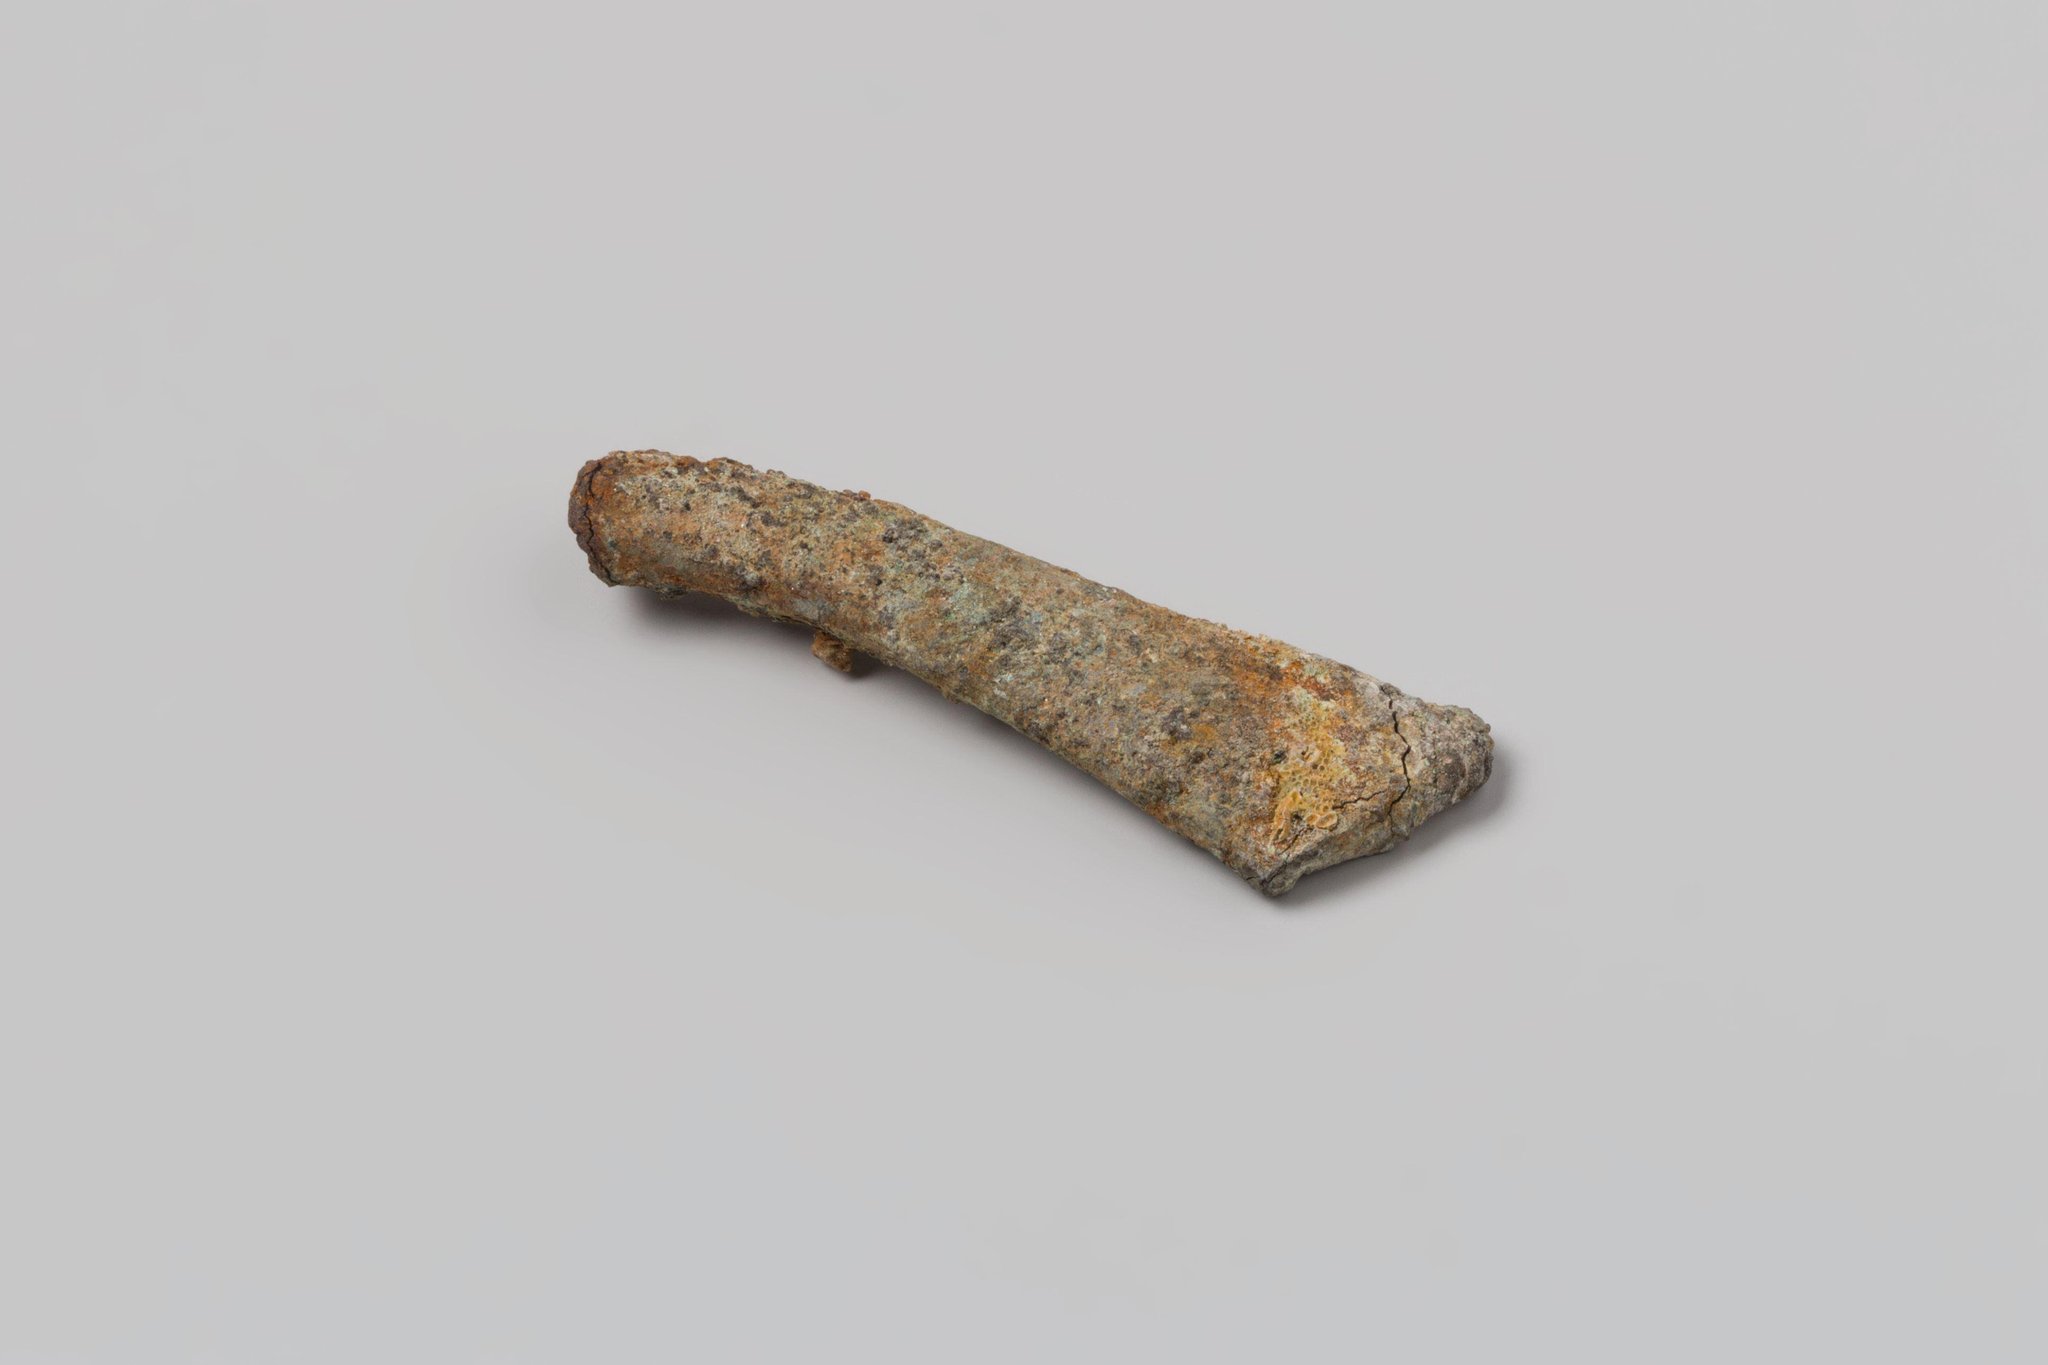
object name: fork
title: Fragment steel van vork of lepel uit het wrak van de Oost-Indiëvaarder Hollandia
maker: Anonymous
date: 1700-1743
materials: tin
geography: netherlands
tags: verenigde oostindische compagnie, hollandia (schip), annet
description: Cutlery, fragment: stem of fork or spoon; fragm, flat, widening, corroded.